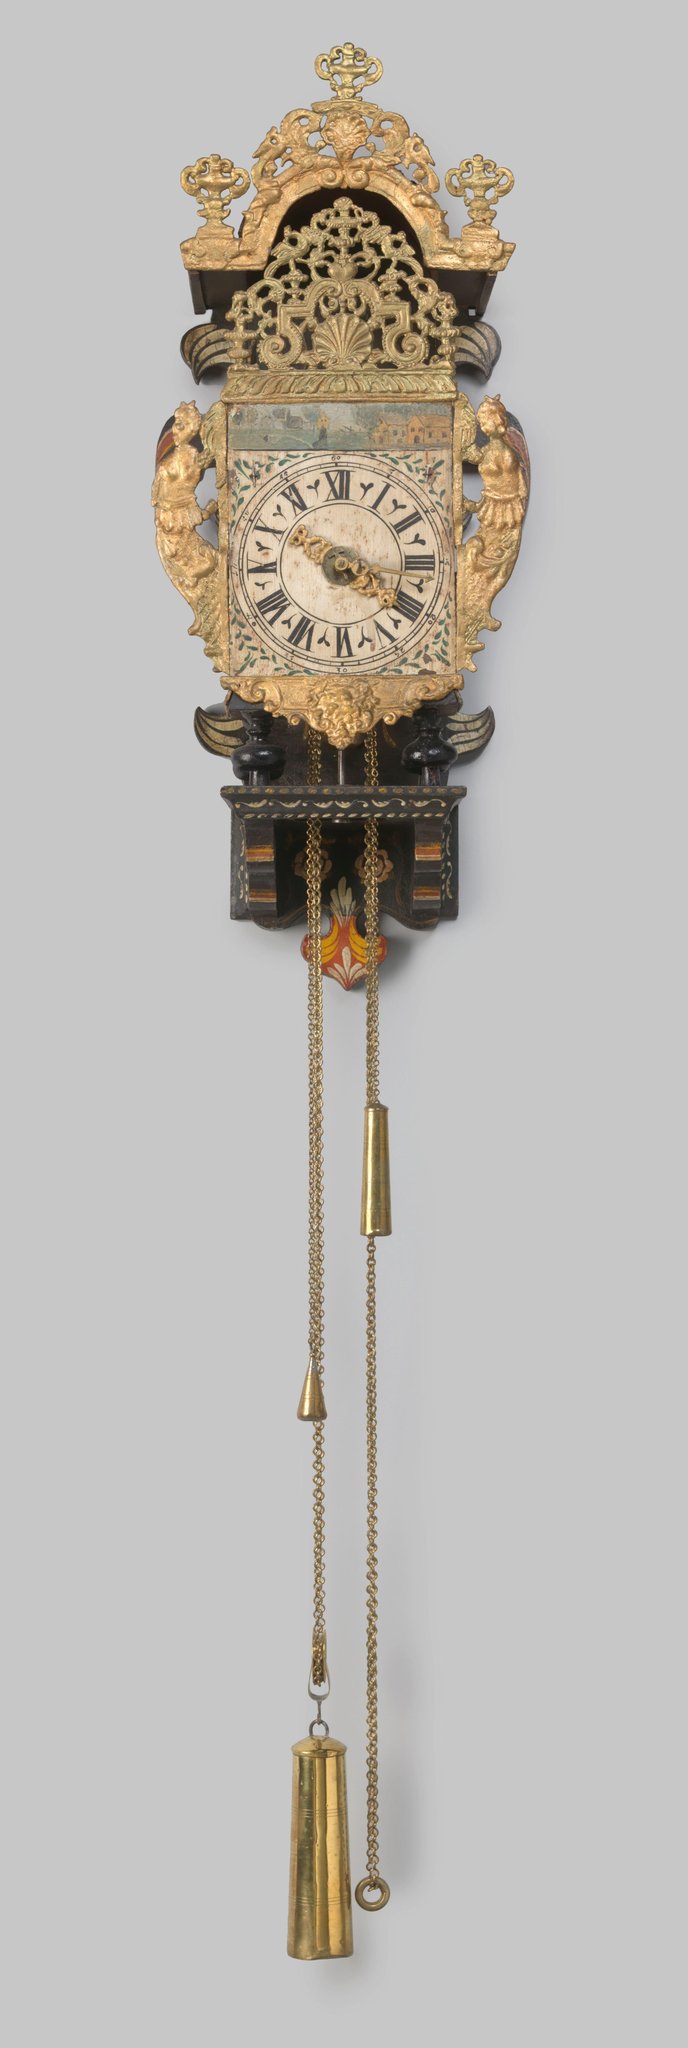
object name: mechanical clock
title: Stoelklok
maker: Anonymous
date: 1785-1800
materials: cardboard, glass, iron, lead, wood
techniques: gilding, painted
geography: northern netherlands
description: Stoelklok, met een stoel van eikenhout, donkergroen geschilderd met gekleurde blad- en bloemmotieven. Op een console onderaan rust een stoel met gedraaide poten. Versieringen op lood. De ijzeren uurwerkkast heeft aan de zijkanten twee deuren met glasruitjes. Op de koperen wijzerplaat zijn groene bladmotieven en een landschap met huizen geschilderd. Verder versierde verguld loden platen met schelp, bandwerk, vazen, vogelmotieven en aan de zijkanten meerminnen met bladwerk tegen een geruite achtergrond.